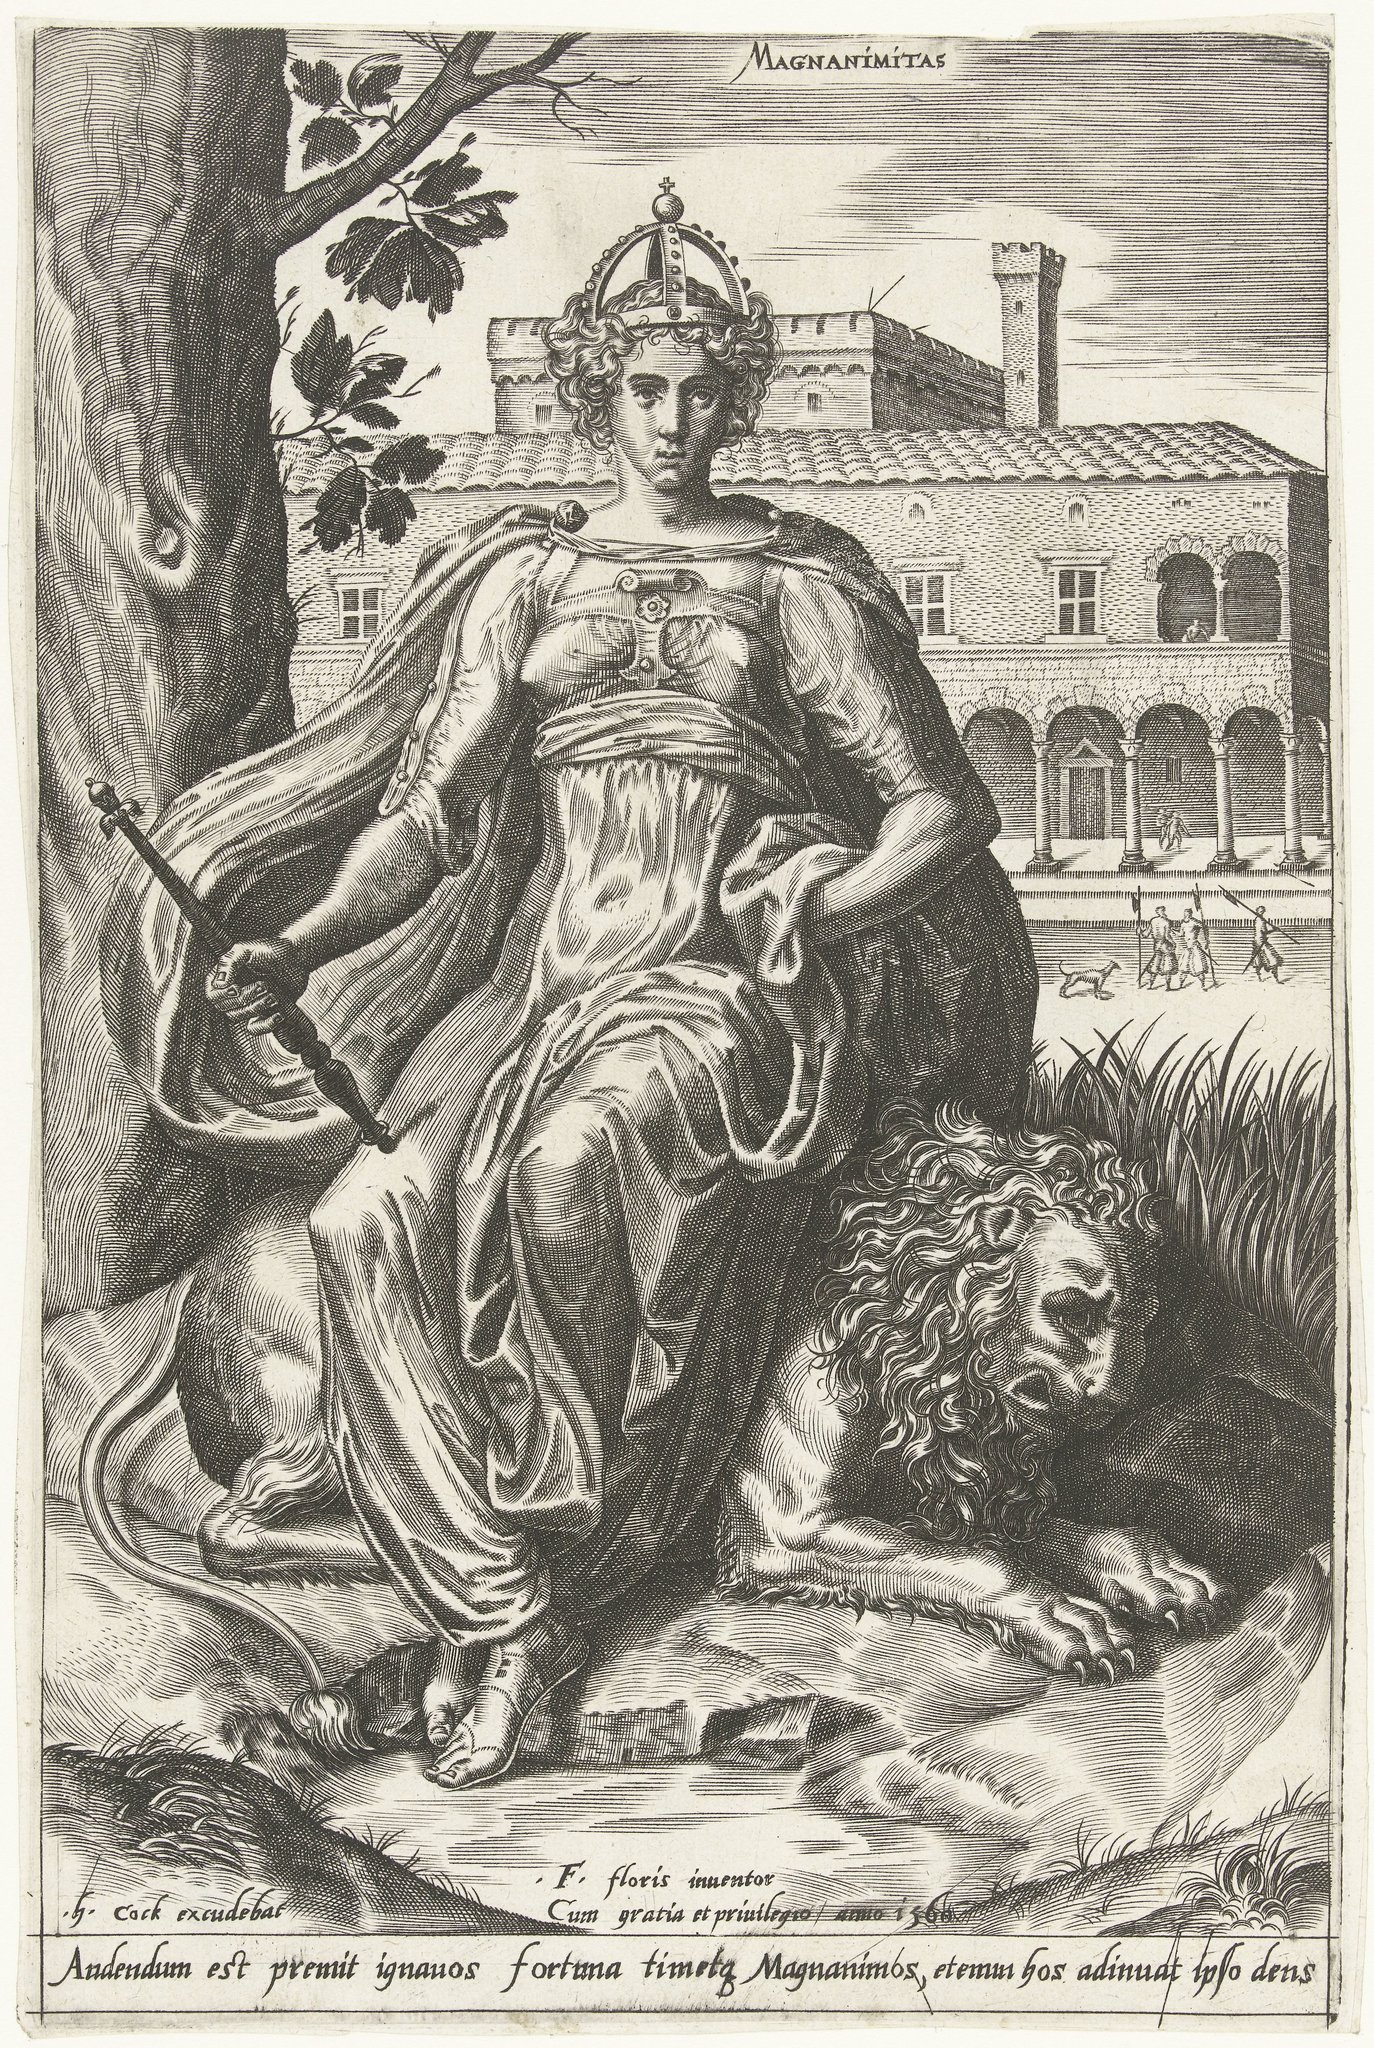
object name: print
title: Edelmoedigheid (Magnanimitas)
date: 1560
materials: paper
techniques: engraving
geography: antwerp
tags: magnanimity; 'grandezza e robustezza d'animo', 'magnanimità' (ripa)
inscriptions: collector's mark: Lugt 2228, collector's mark: Lugt 2760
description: De personificatie van de Edelmoedigheid troont als een vorstin, met kroon en scepter, op een leeuw. Op de achtergrond een plein voor een palazzo met zuilengalerij.